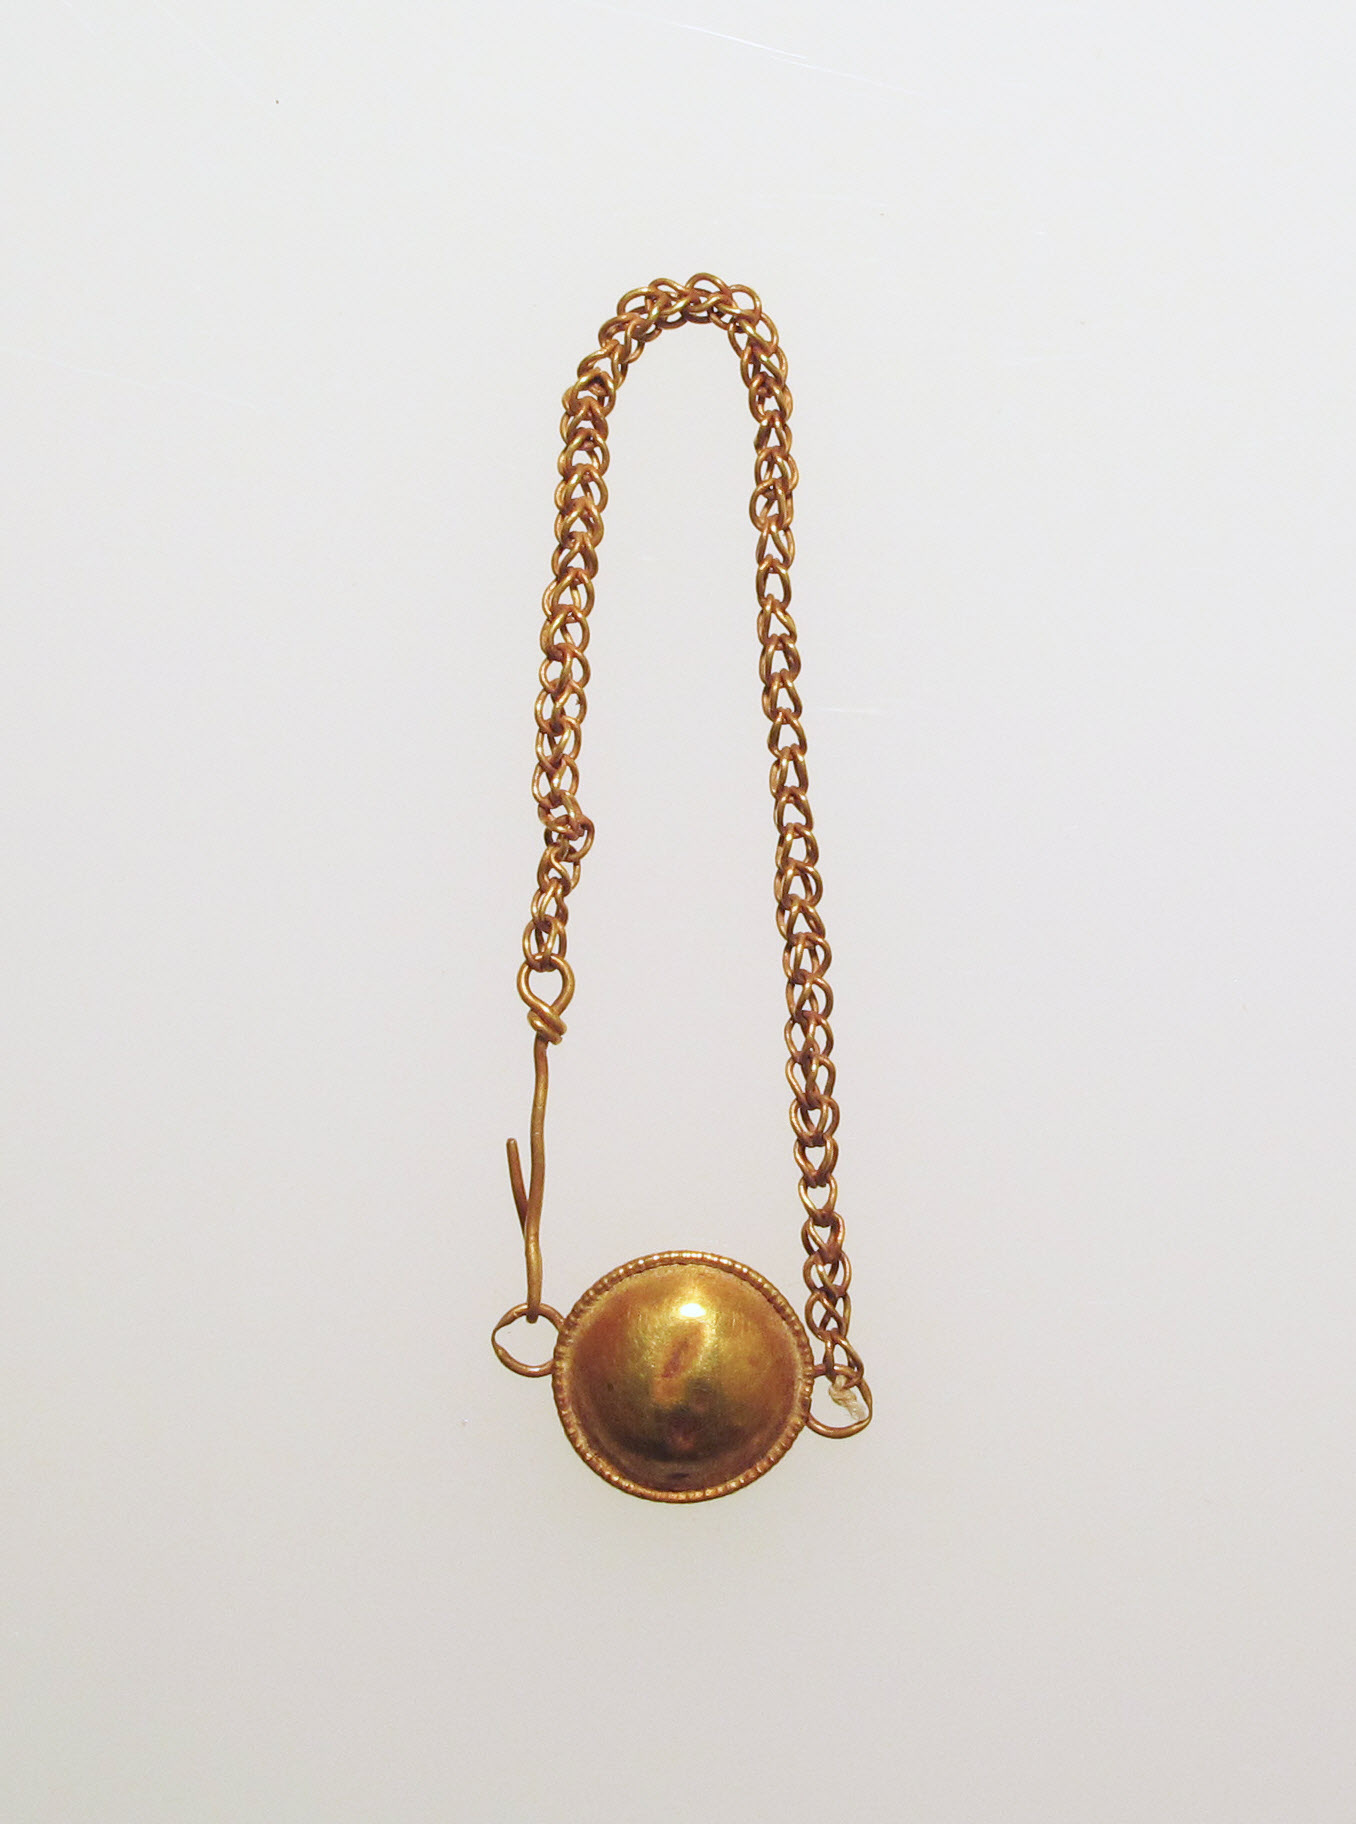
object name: earring, chain type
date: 7000 BCE-330 CE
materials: gold